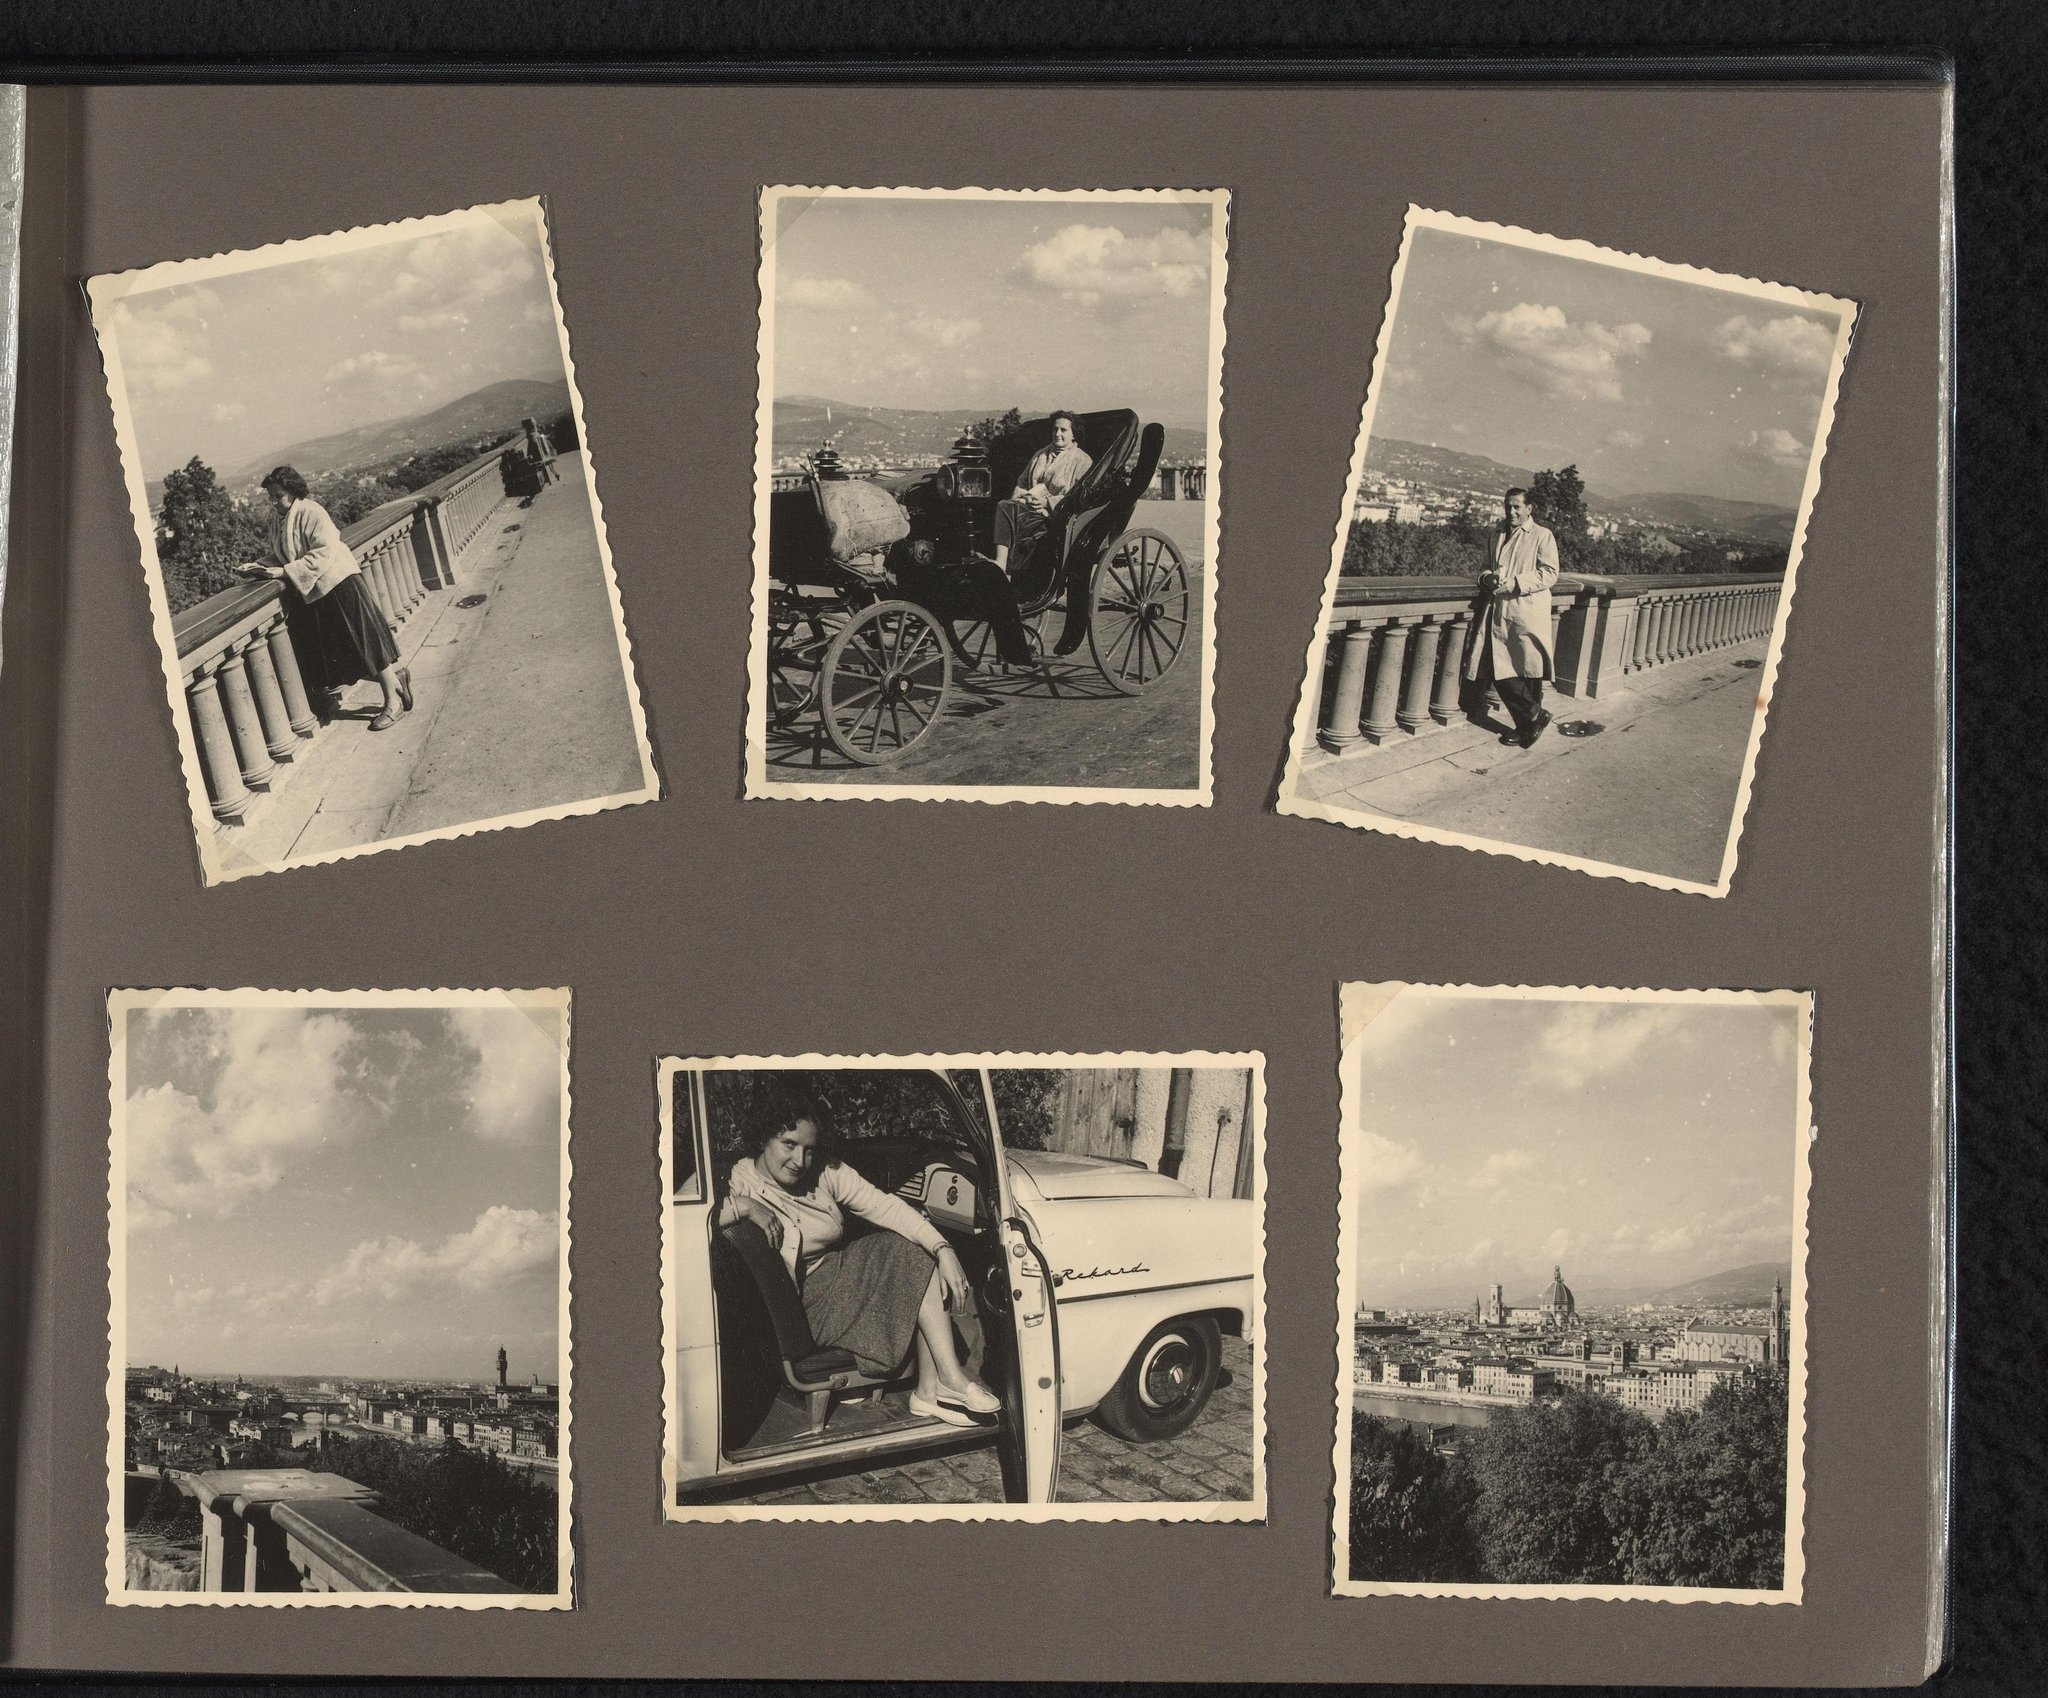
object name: photograph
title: Isabel Wachenheimer en haar derde echtgenoot Gideon Elon in Florence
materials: paper, cardboard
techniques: gelatin silver print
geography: florence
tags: leiden, isabel wachenheimer-elon, gideon elon, city-view in general; 'veduta', historical persons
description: Blad bevat zes foto's van Gideon Elon en Isabel Wachenheimer. Deze foto's maken deel uit van een album.